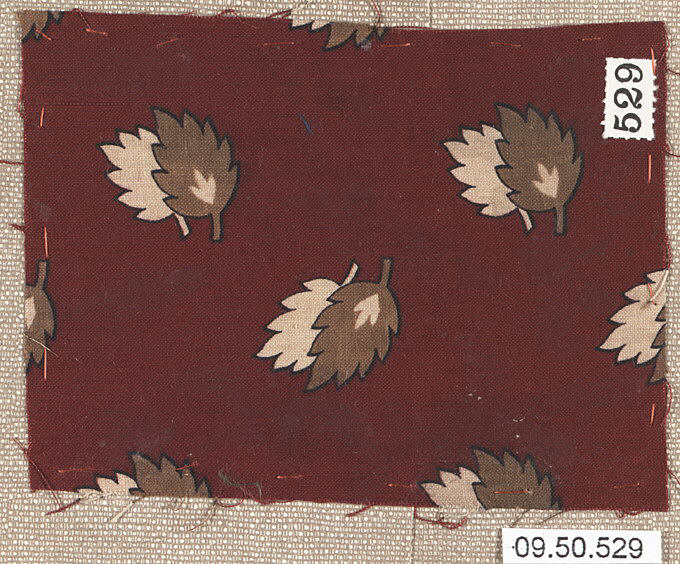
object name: piece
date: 1801-1900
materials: cotton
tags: leaves